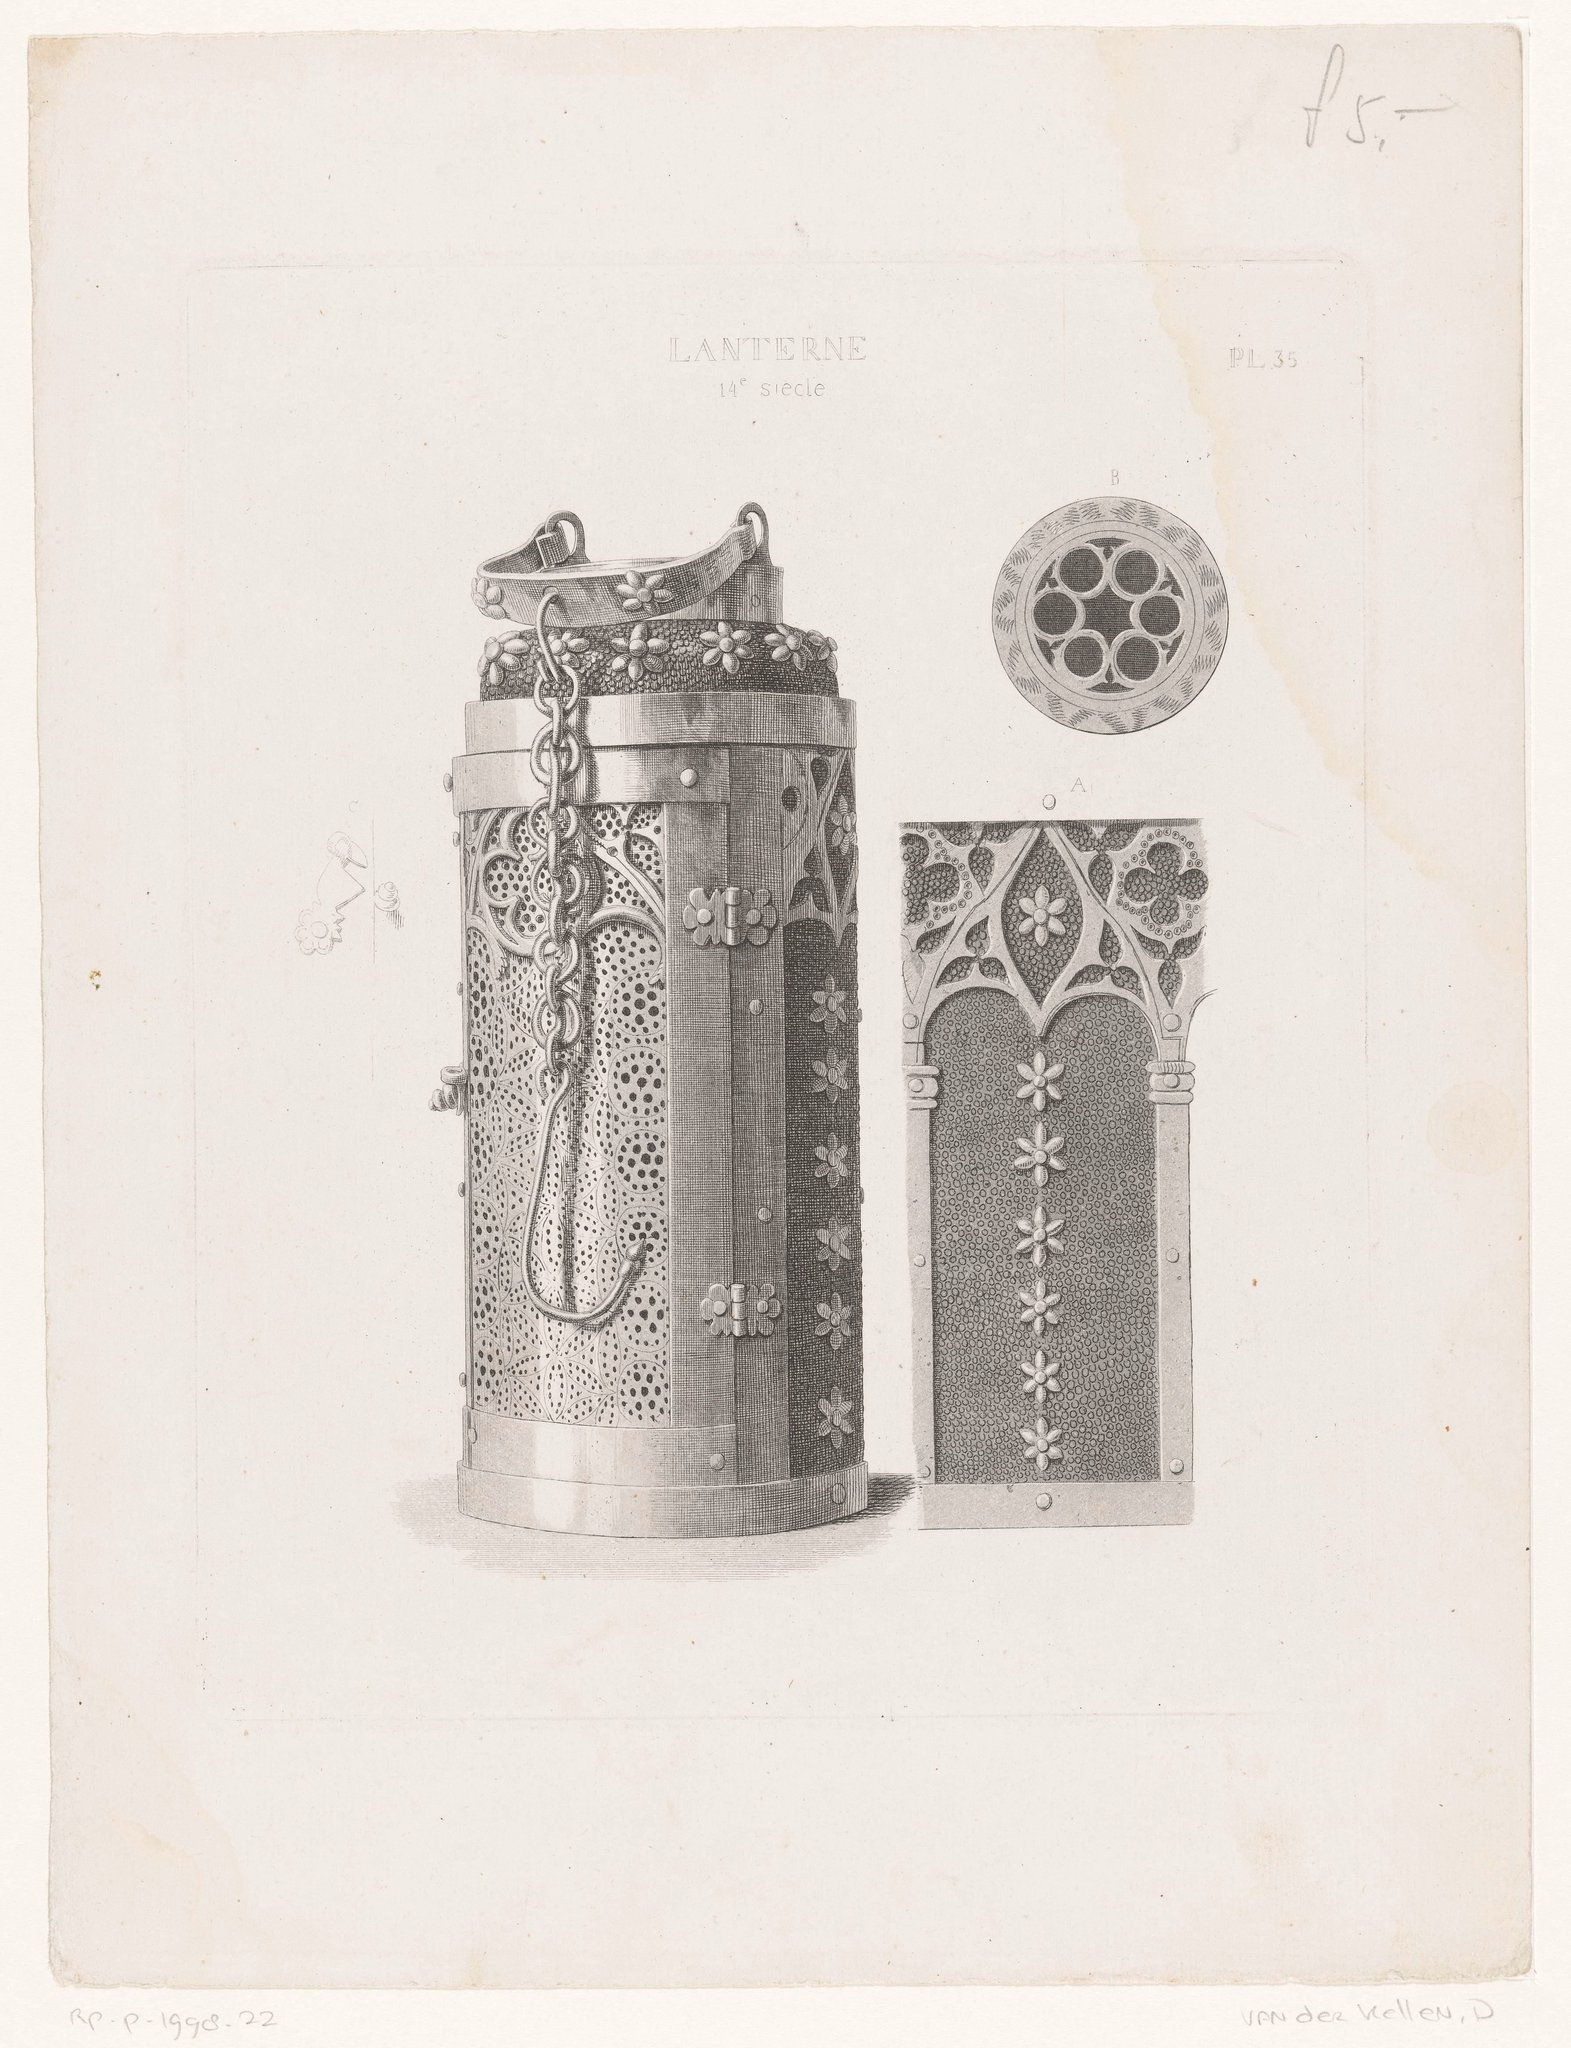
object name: print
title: Lantaarn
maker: david van der kellen (1804-1879)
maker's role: die cutter, draughtsman, print maker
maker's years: 1804-1879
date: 1865-1878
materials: paper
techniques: etching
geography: netherlands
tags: lantern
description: Een koperen handlantaarn uit de veertiende de eeuw.